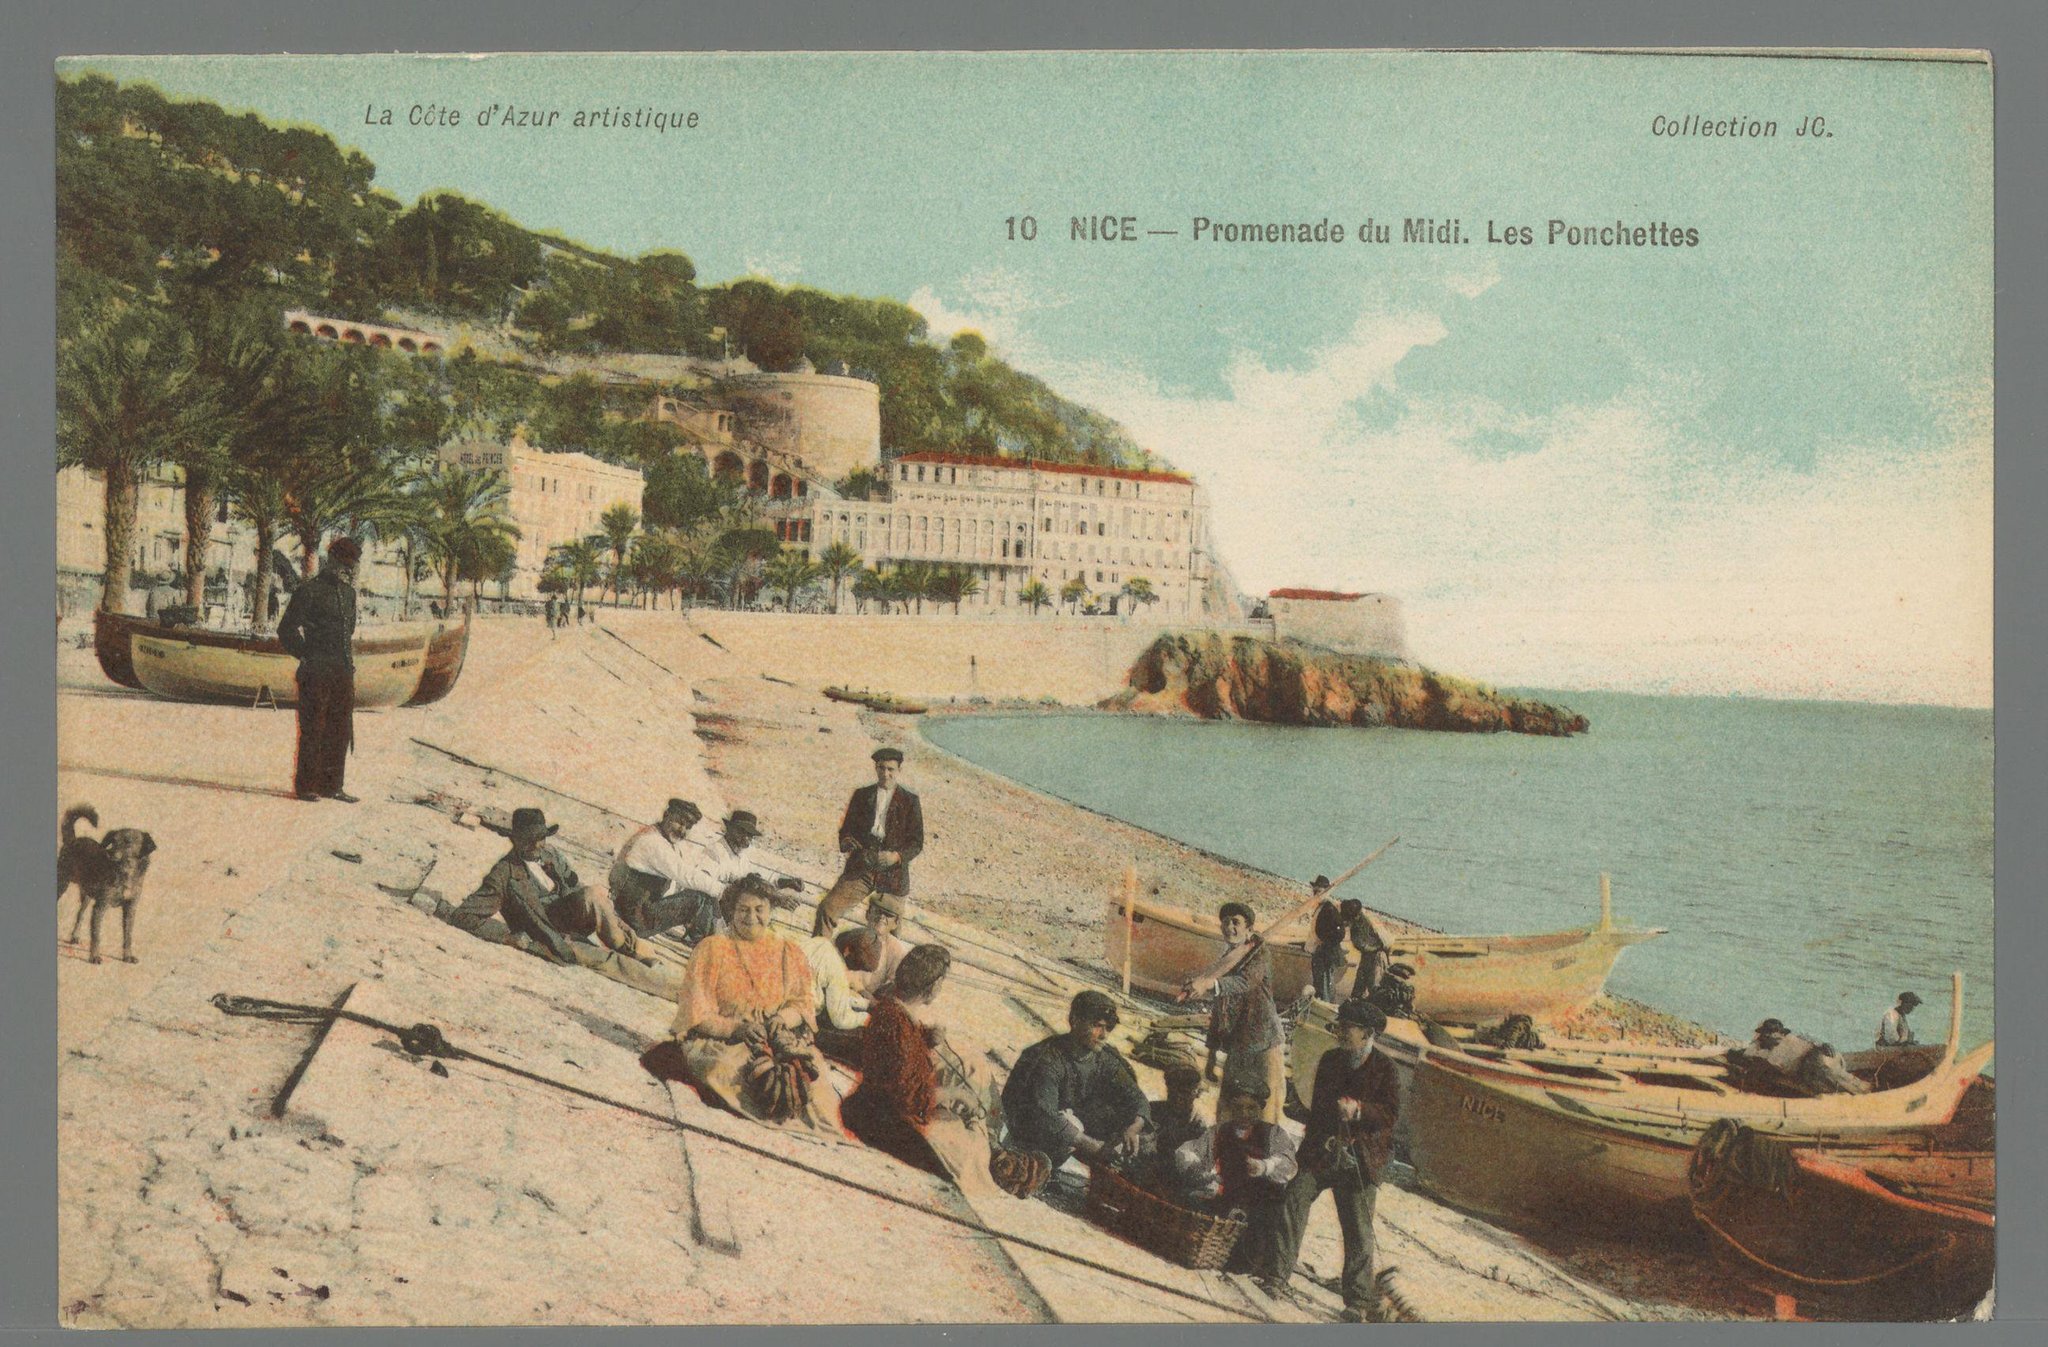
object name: ansichtkaart, prentbriefkaart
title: Nice. Promenade du Midi. Les Ponchettes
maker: Anonymous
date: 1904-1906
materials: cardboard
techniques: photograph, lithograph, writing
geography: nice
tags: urban housing, in or beside the water (on the beach)